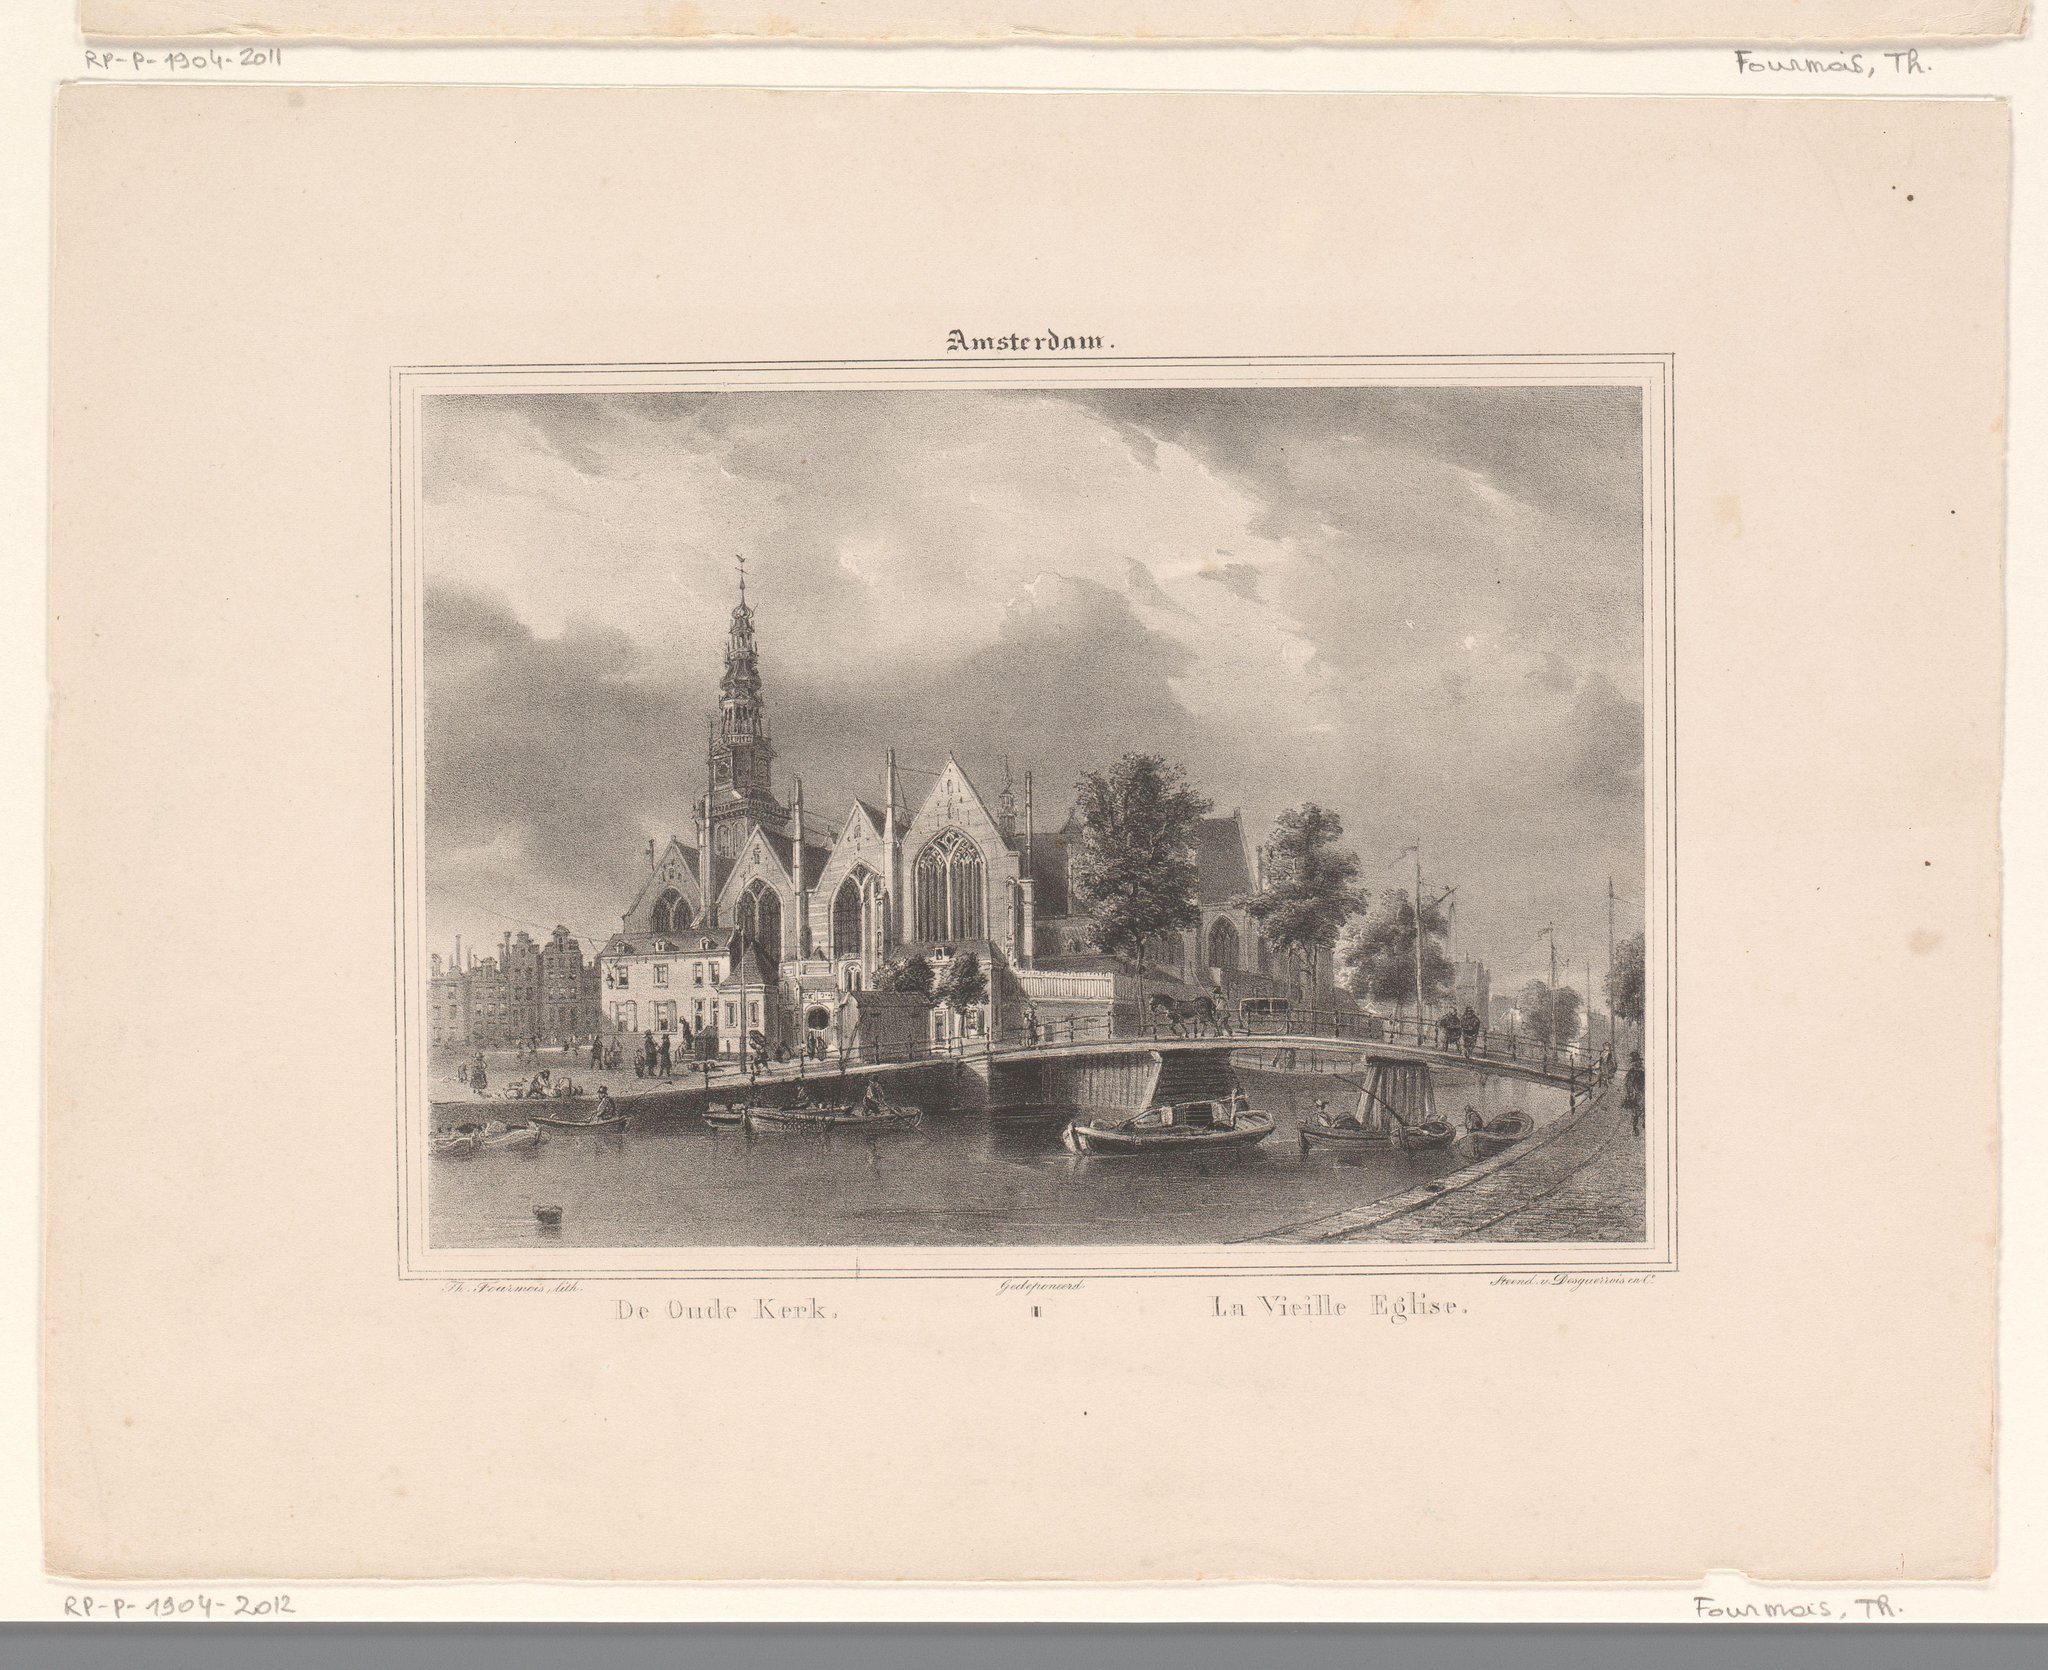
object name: print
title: Het Rokin naar de Beurs, voor de slooping in 1837 / Le Rokin de côté de la Bourse, avant sa démolition en 1837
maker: théodore fourmois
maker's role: print maker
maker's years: 1814-1871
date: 1837-1840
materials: paper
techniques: lithograph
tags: canals, waters (in city), boat propelled by man or animal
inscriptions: : ‘Gedeponeerd’, collector's mark: Lugt 2228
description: Prent behoort mogelijk tot een serie met gezichten op Amsterdam, Rotterdam, Haarlem, Den Haag en Huis te Brederode. Desguerrois heeft hier midden jaren dertig opdracht voor gegeven aan onder meer Lauters, Fourmois en Clerman.